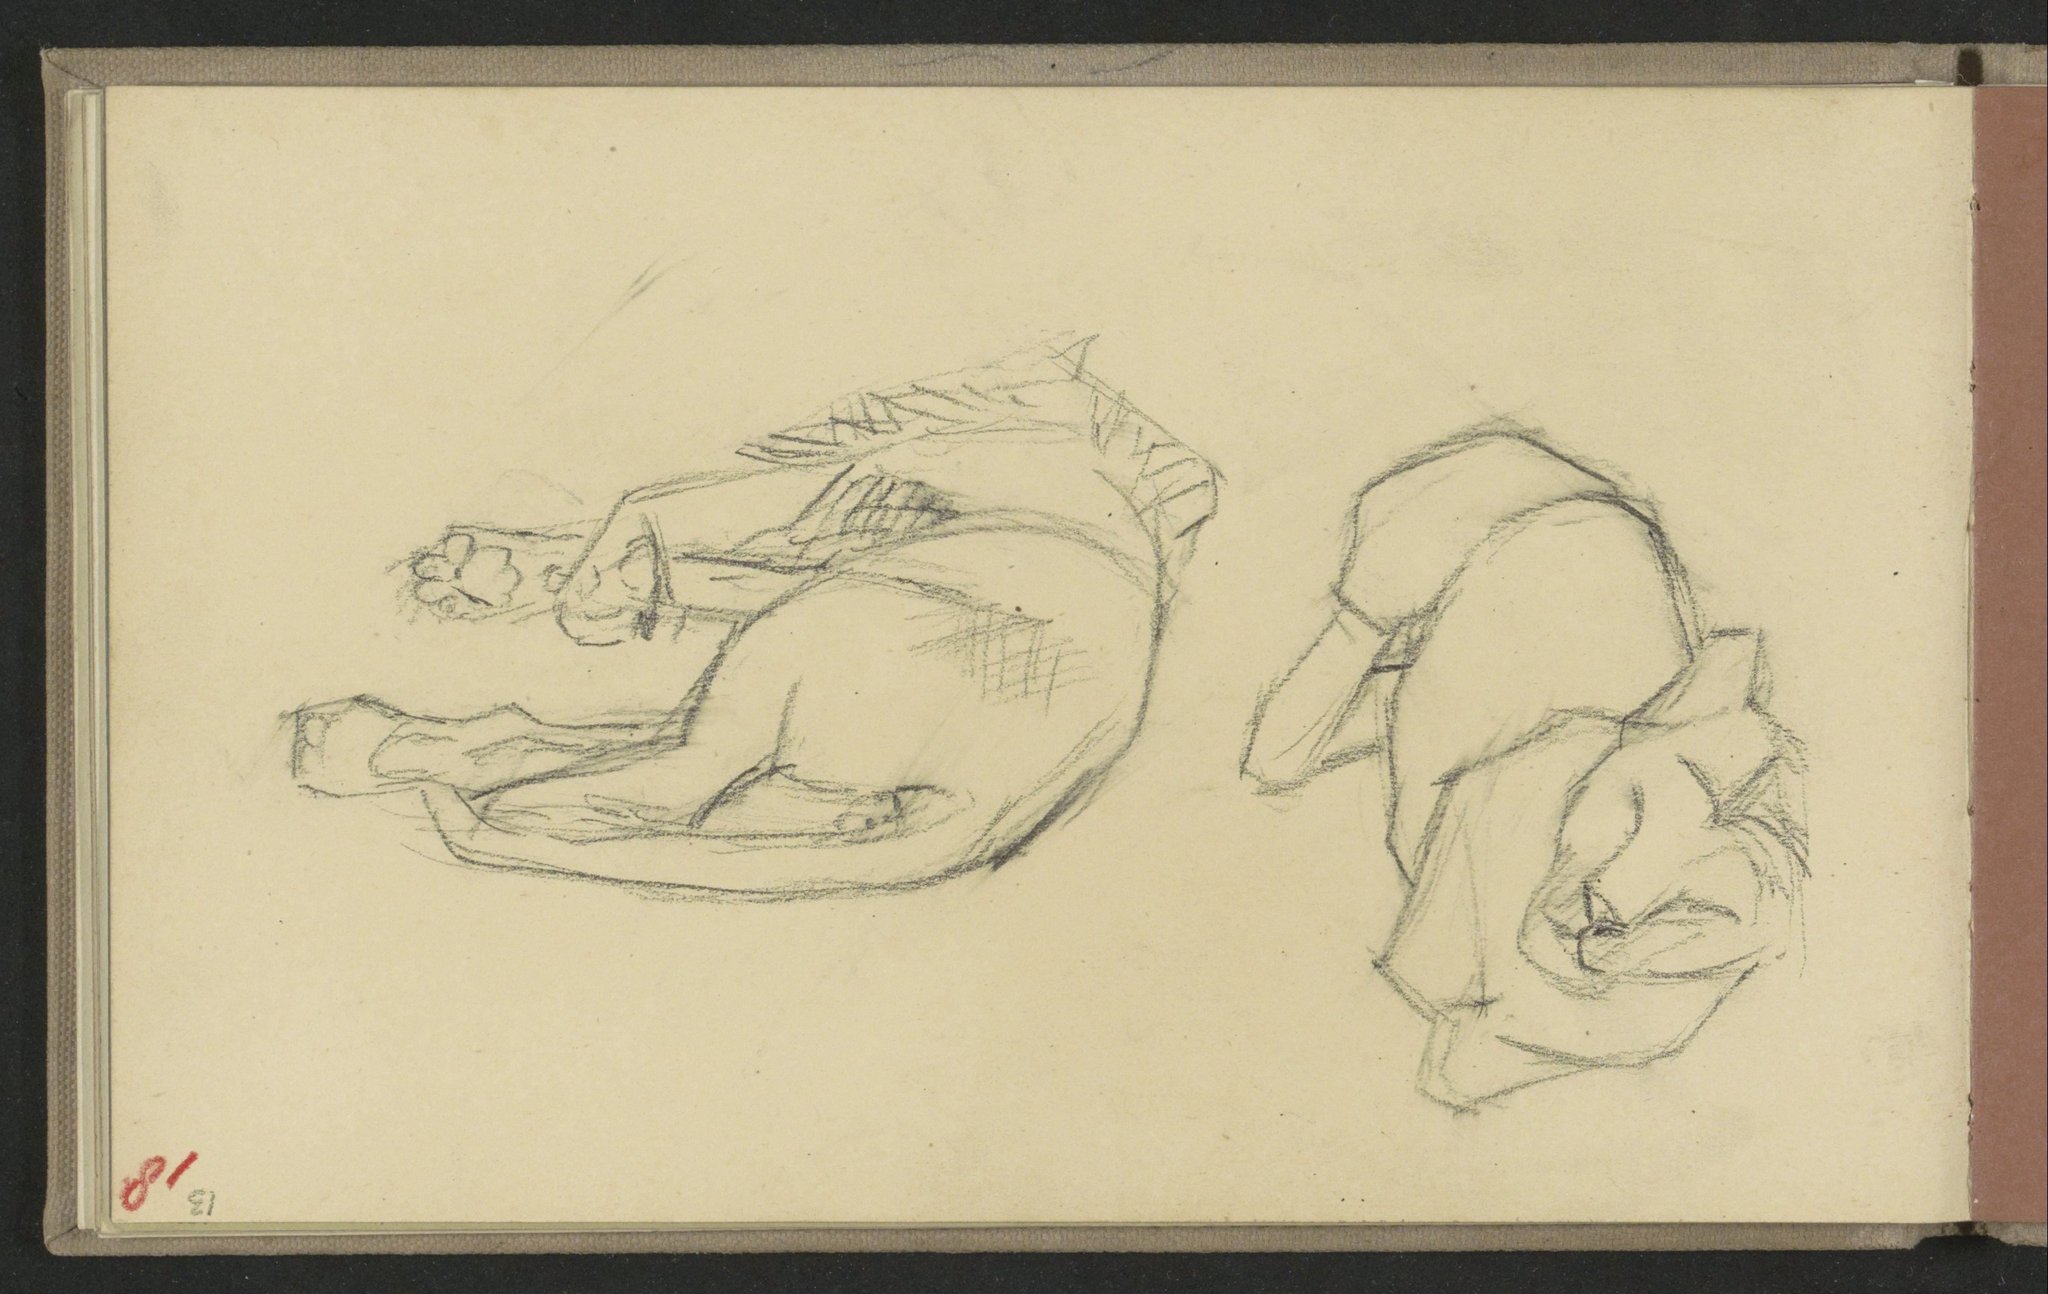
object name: sketchbook leaf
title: Lopend en liggend dier, mogelijk een leeuw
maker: jozef israëls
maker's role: draughtsman, painter, print maker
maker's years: 1824-1911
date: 1834-1911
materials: paper, pencil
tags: animals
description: Blad 13 verso uit een schetsboek met 26 bladen.